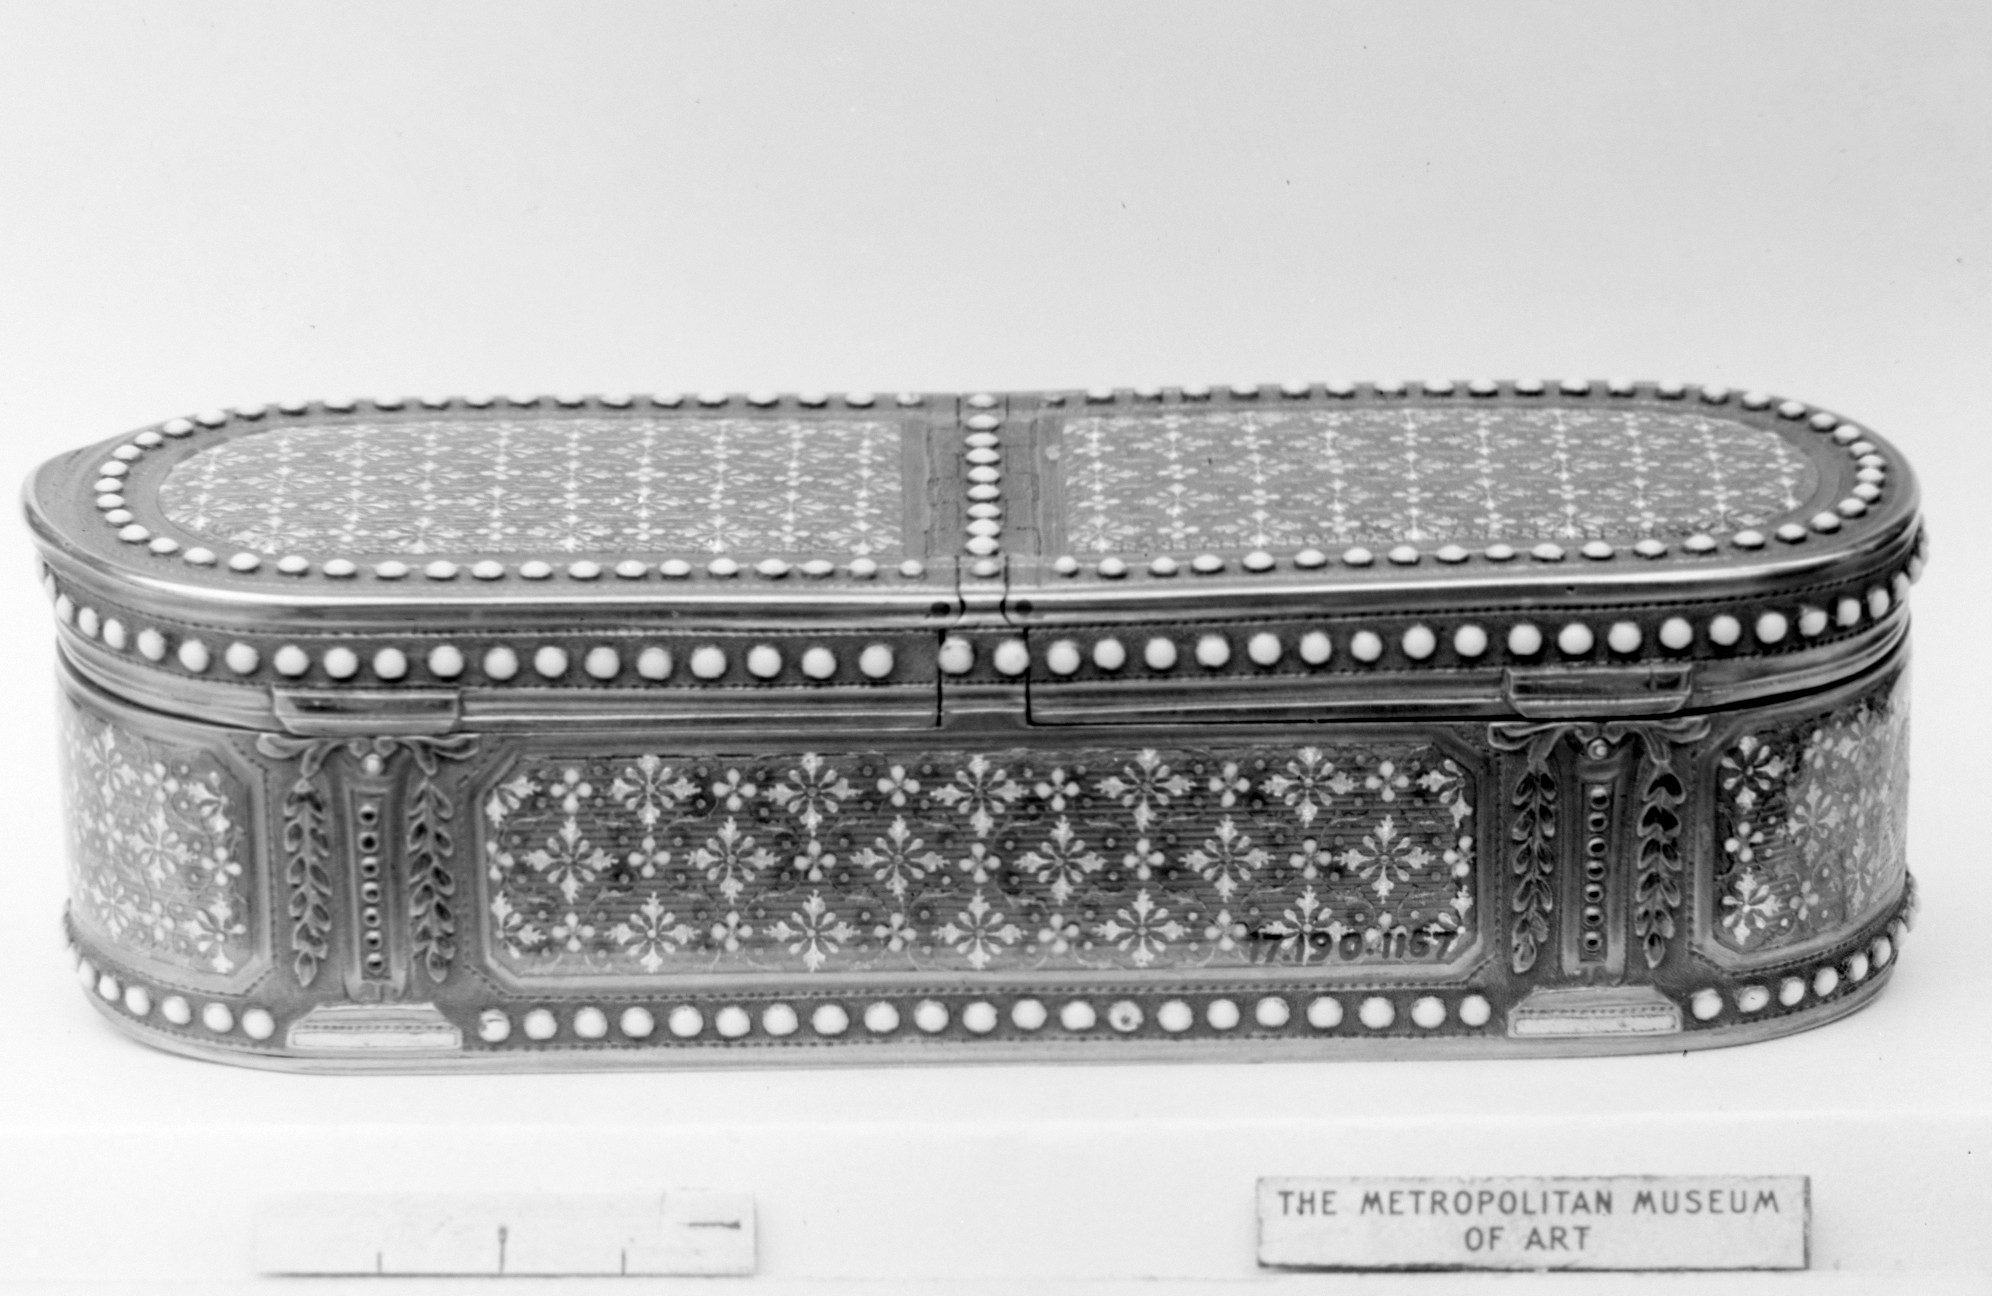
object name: snuffbox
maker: pierre-innocent zurich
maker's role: maker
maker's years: 1780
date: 1782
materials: enamel, gold